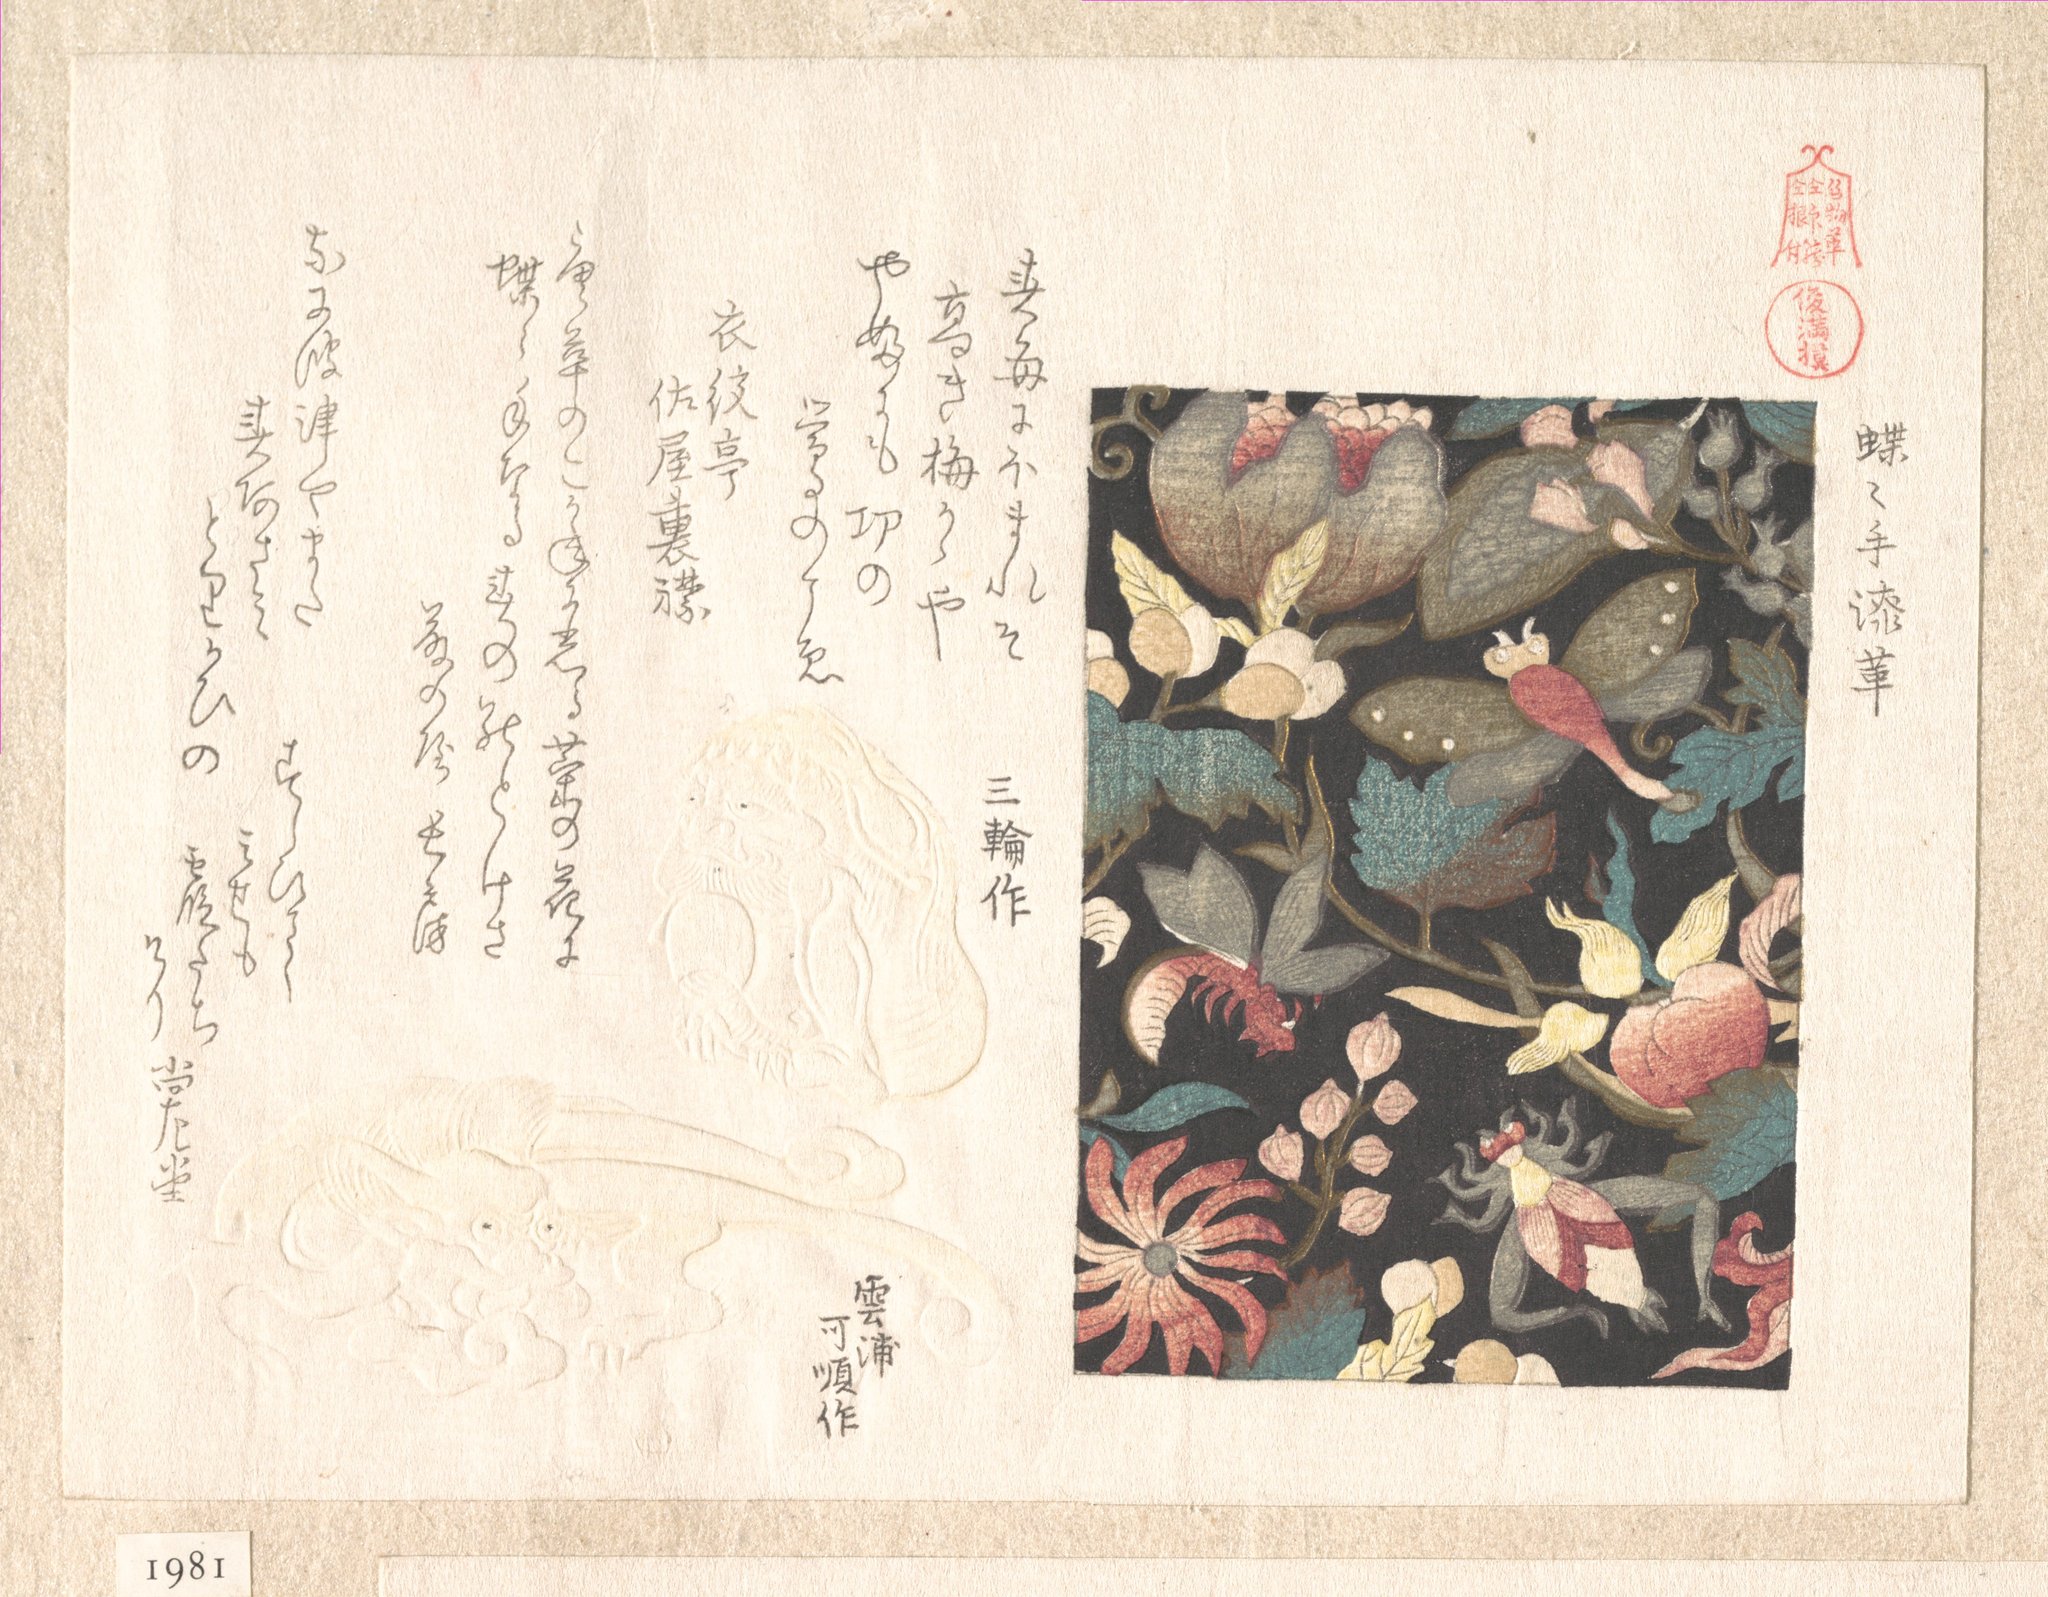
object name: print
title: Design for Leather and Netsuke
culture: japanese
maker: kubo shunman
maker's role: artist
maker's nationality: japanese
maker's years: 1757-1820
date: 1801-1900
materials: ink, paper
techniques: surimono, woodblock print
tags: insects,dragonflies,flowers